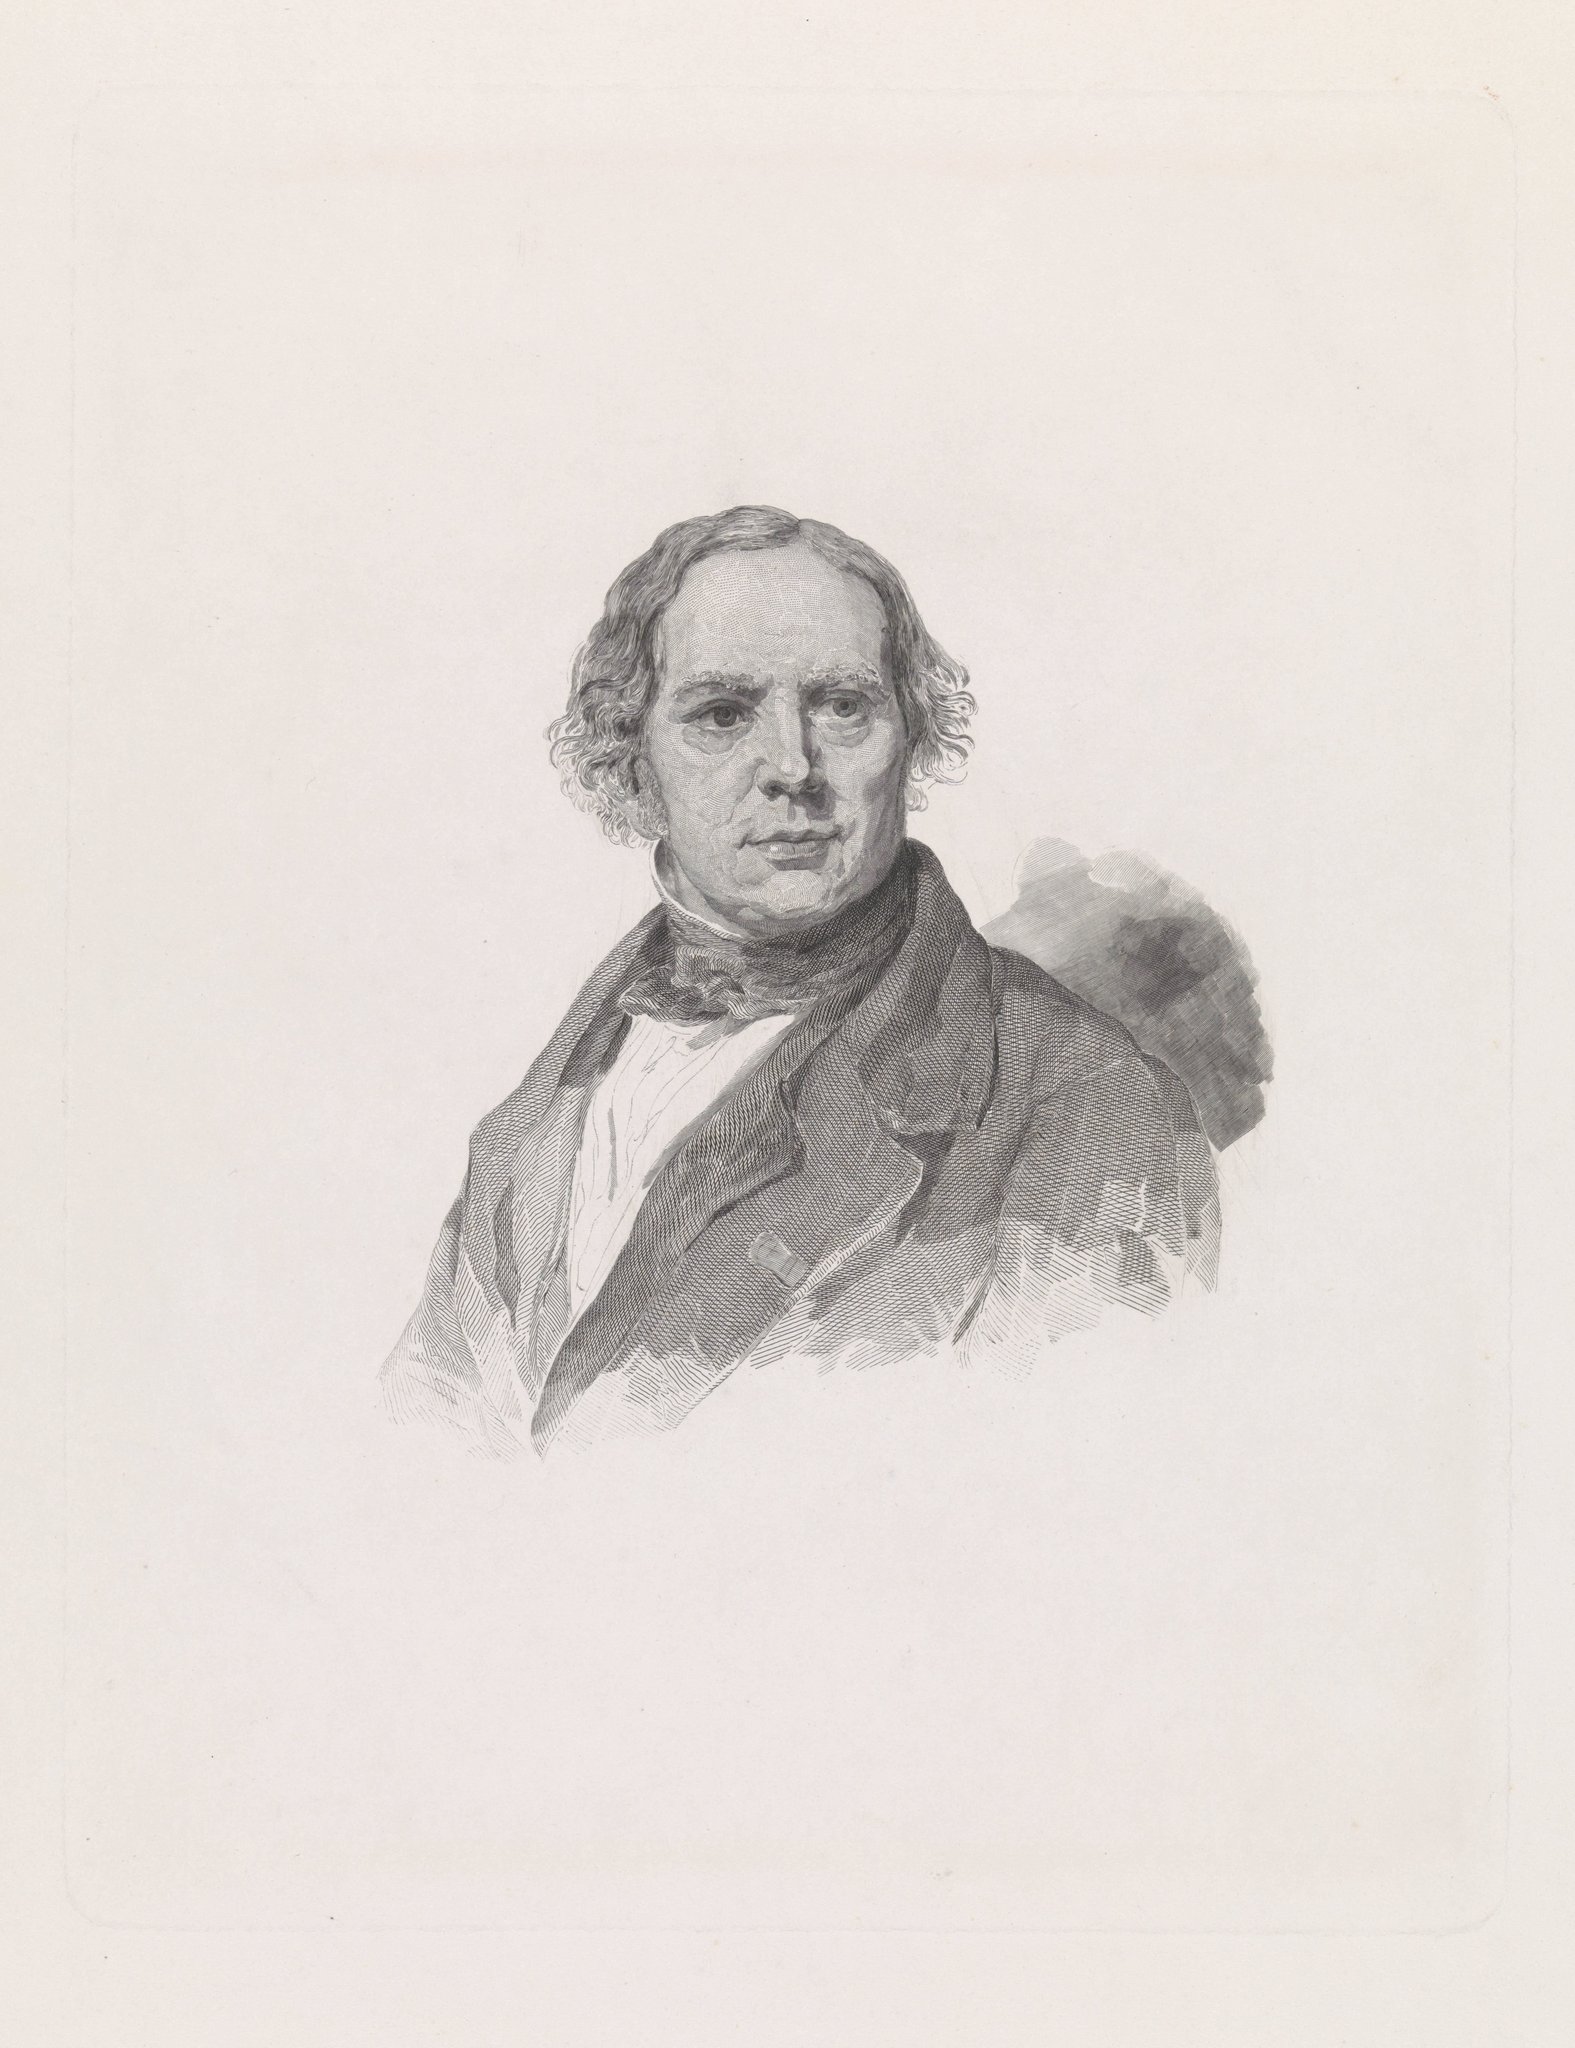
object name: print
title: Portret van Jan Willem Pieneman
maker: johann wilhelm kaiser (i)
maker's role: draughtsman, print maker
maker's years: 1813-1900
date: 1846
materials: paper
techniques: etching, roulette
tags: abcoude, painter, jan willem pieneman, historical persons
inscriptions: collector's mark: Lugt 2228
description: Portretbuste naar links van de beeldend kunstenaar Jan Willem Pieneman.